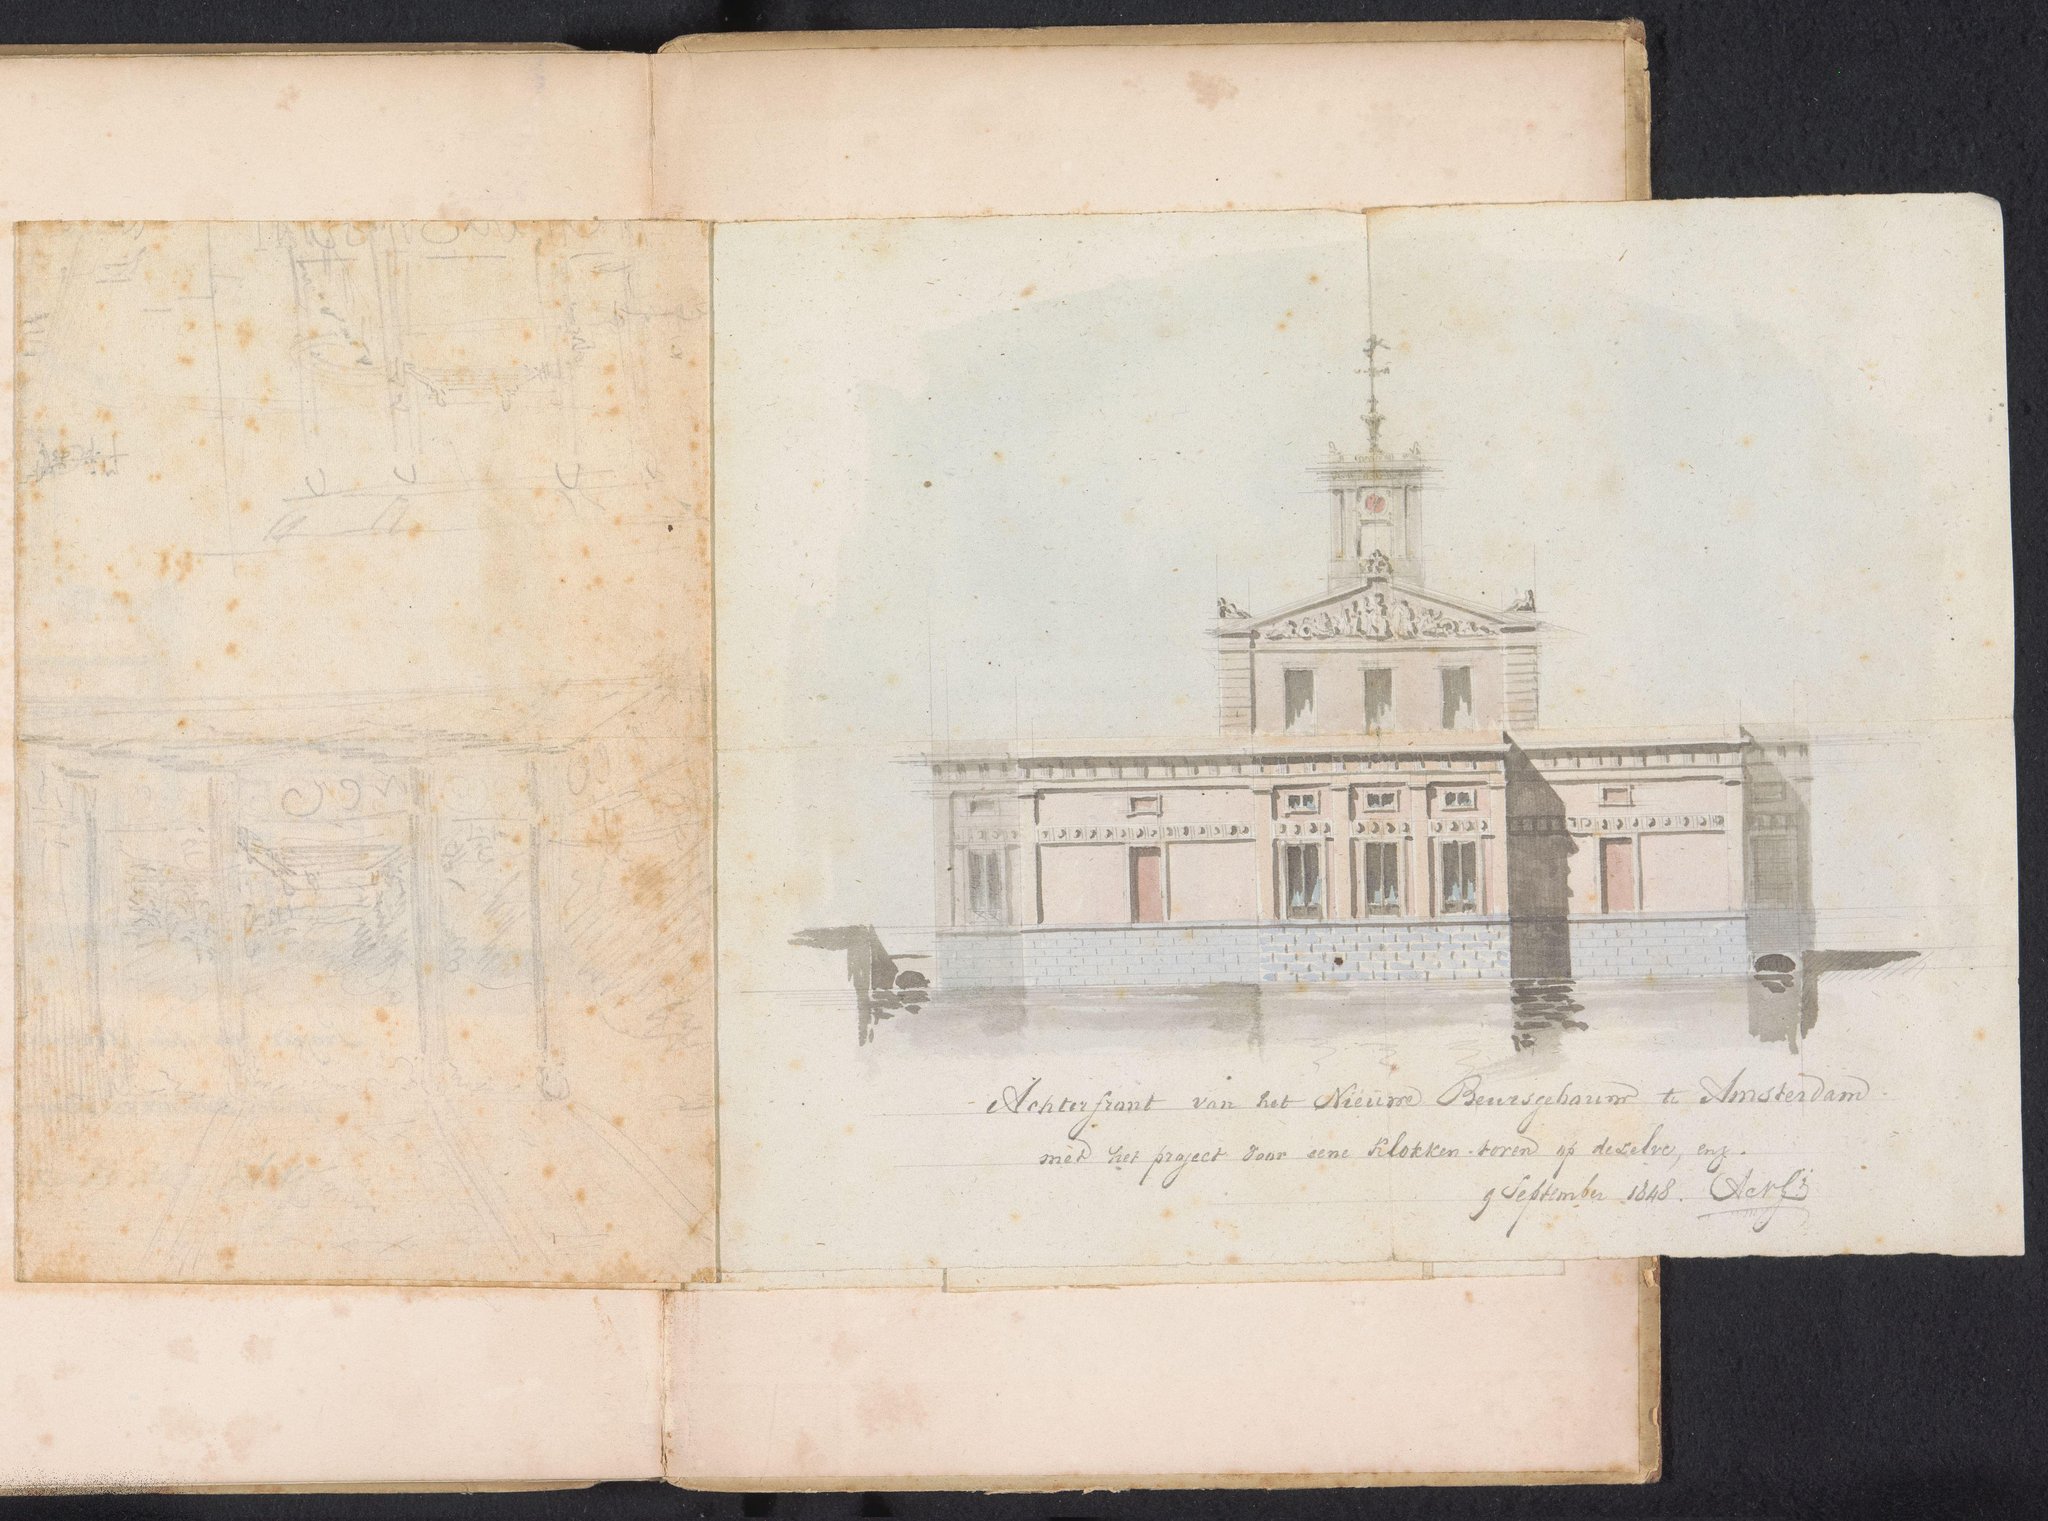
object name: drawing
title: Achterfront van het nieuwe Beursgebouw te Amsterdam met het project voor eene klokken-toren op dezelve, enz.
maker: monogrammist angj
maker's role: draughtsman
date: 1848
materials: paper, pencil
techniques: brush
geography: amsterdam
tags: stock exchange, stock-market, architectural design or model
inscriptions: date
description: Ontwerp voor een klokkentoren op de nieuwe beurs van Zocher te Amsterdam, 1848. Achteraanzicht. Getekende illustratie ingeplakt in een boek uit 1846 over de oude en nieuwe beurs van Amsterdam.